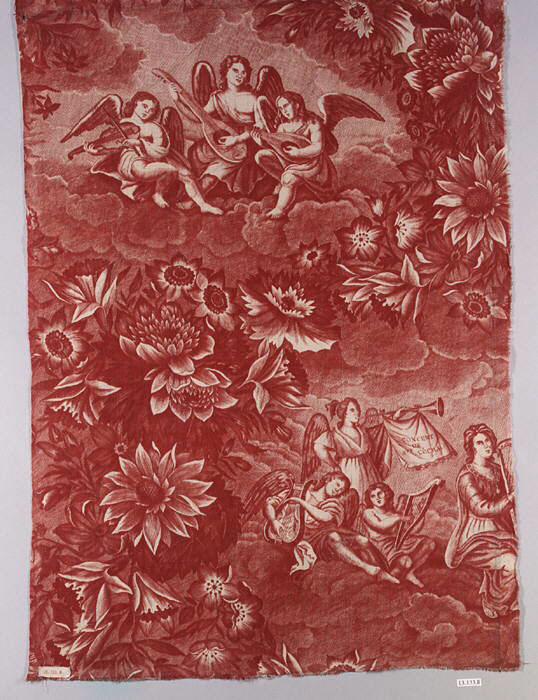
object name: furnishing textile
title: Pictorial print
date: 1825-1830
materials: cotton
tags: musical instruments,flowers,angels